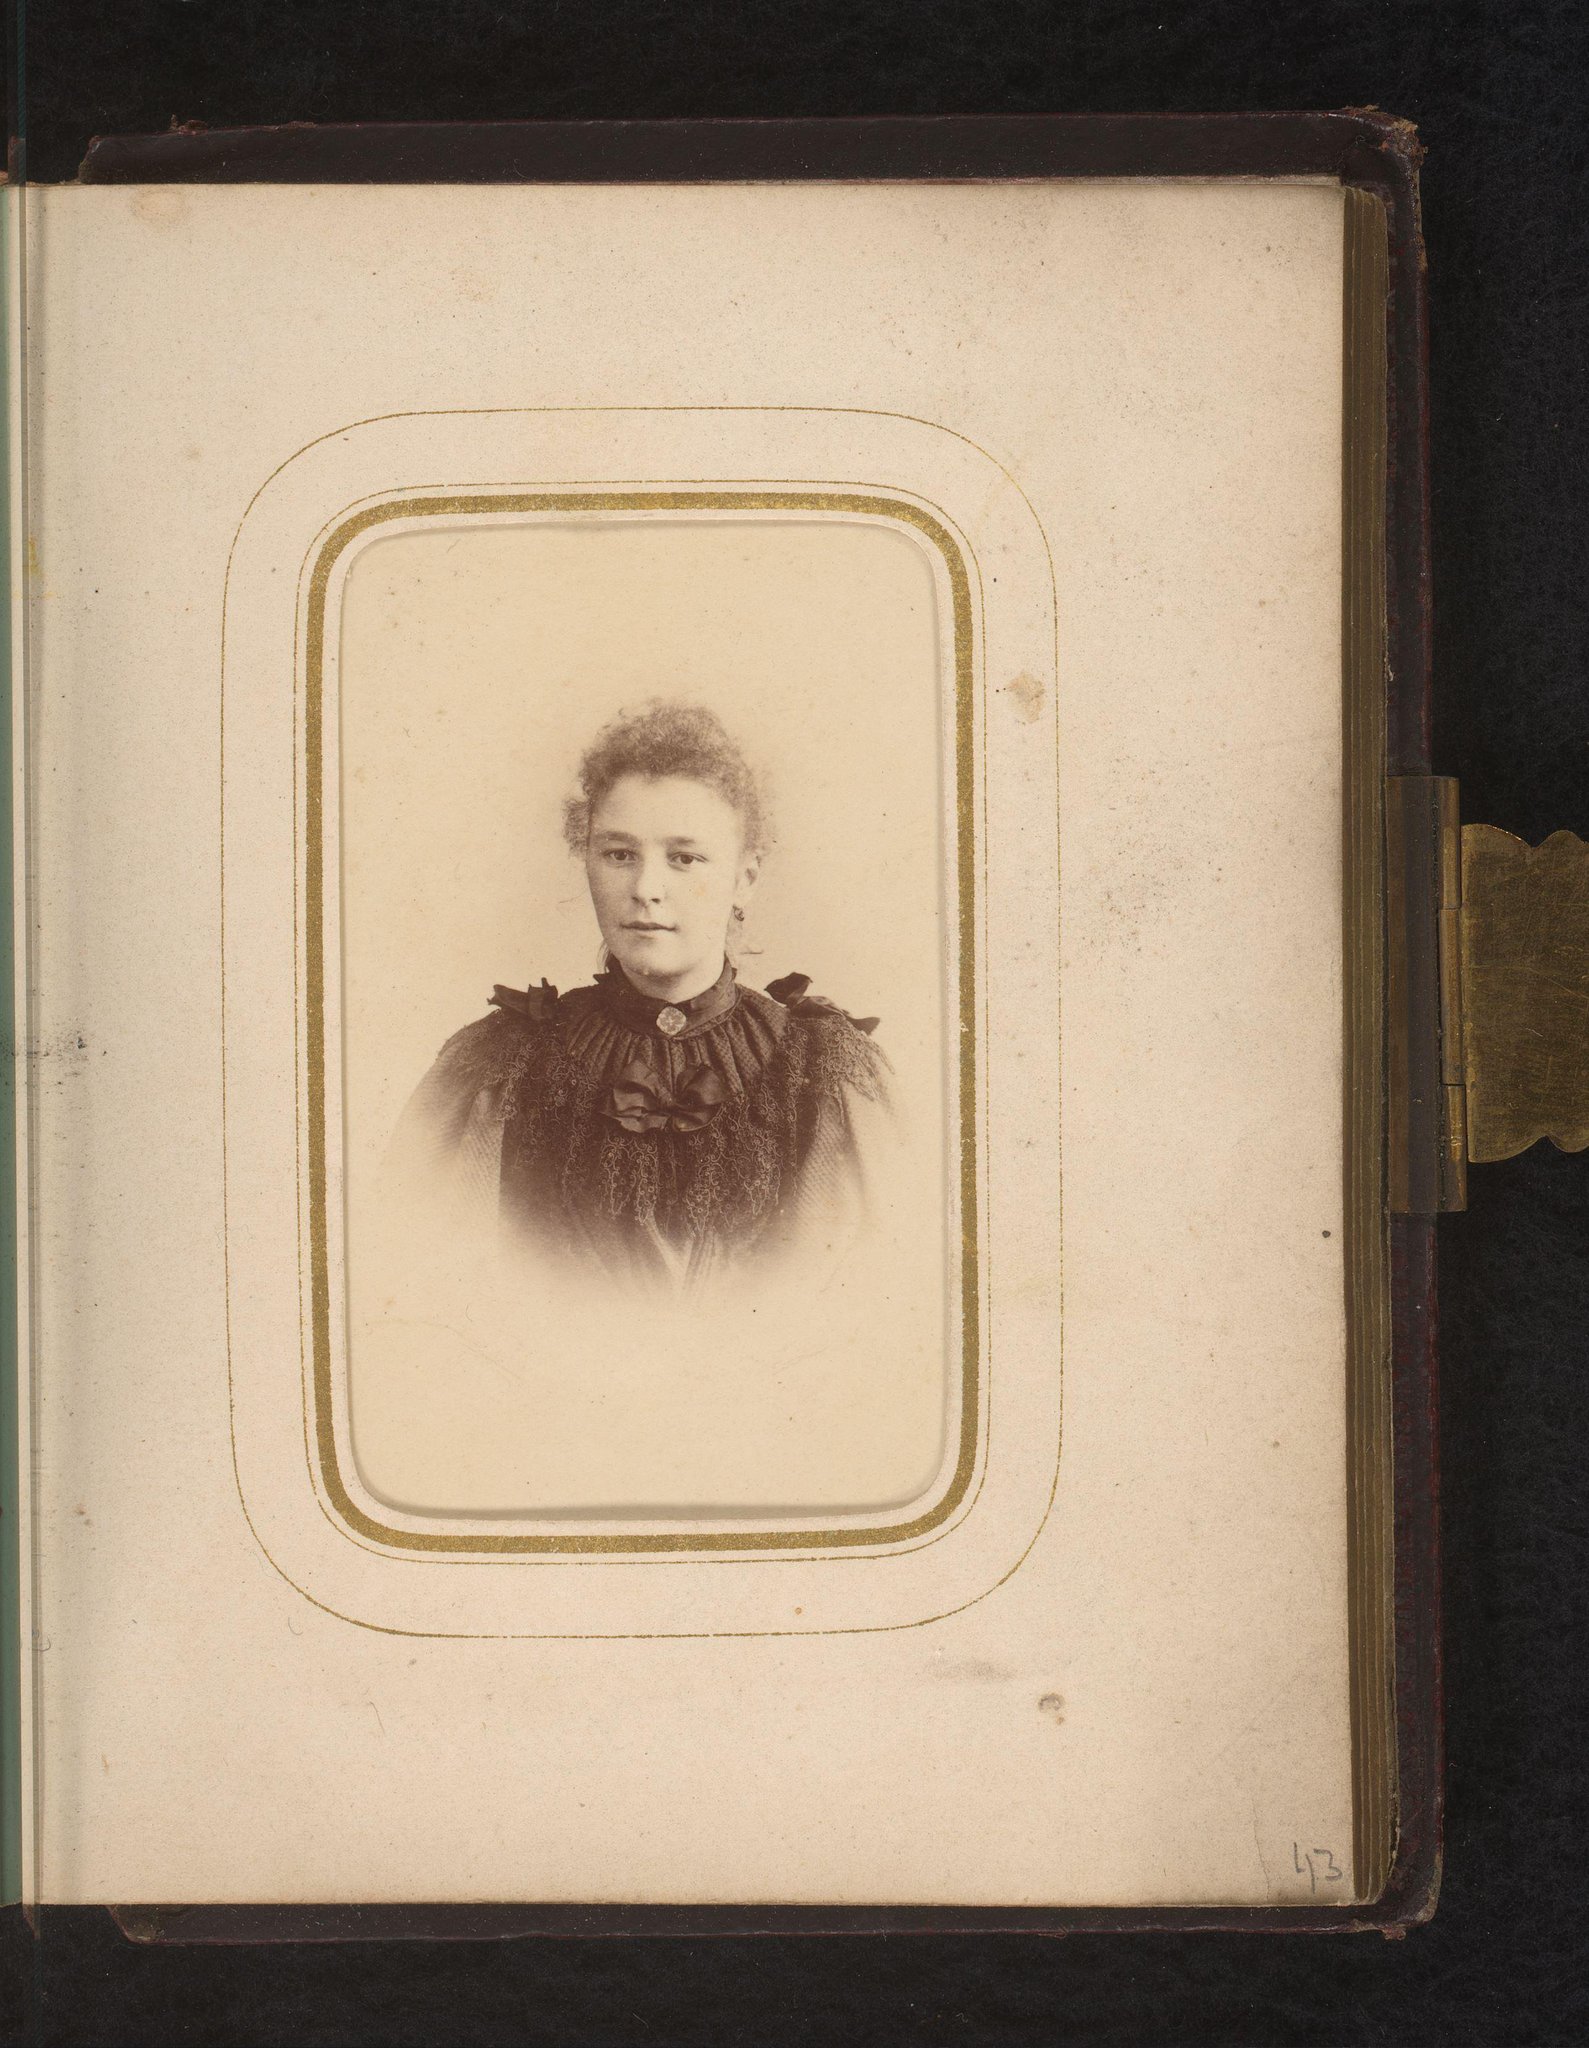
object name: album leaf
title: Portret van een meisje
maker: louis laurent michel yrondy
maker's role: fotograaf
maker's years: 1846-1901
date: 1860-1900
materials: cardboard, photographic support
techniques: albumen print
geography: fougères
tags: girl (child between toddler and youth)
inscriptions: inscription: ‘L. Yrondy/ Photographie Brevete S.G.D.G/ 2, Rue Nationale/ Fougères’